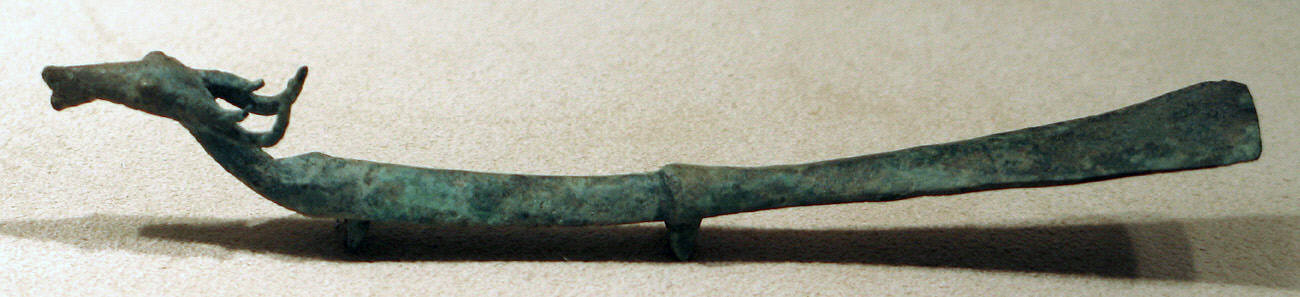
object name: spatula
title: Lime Spatula with Animal Head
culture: indonesian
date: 500 BCE-300 CE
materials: bronze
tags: animals